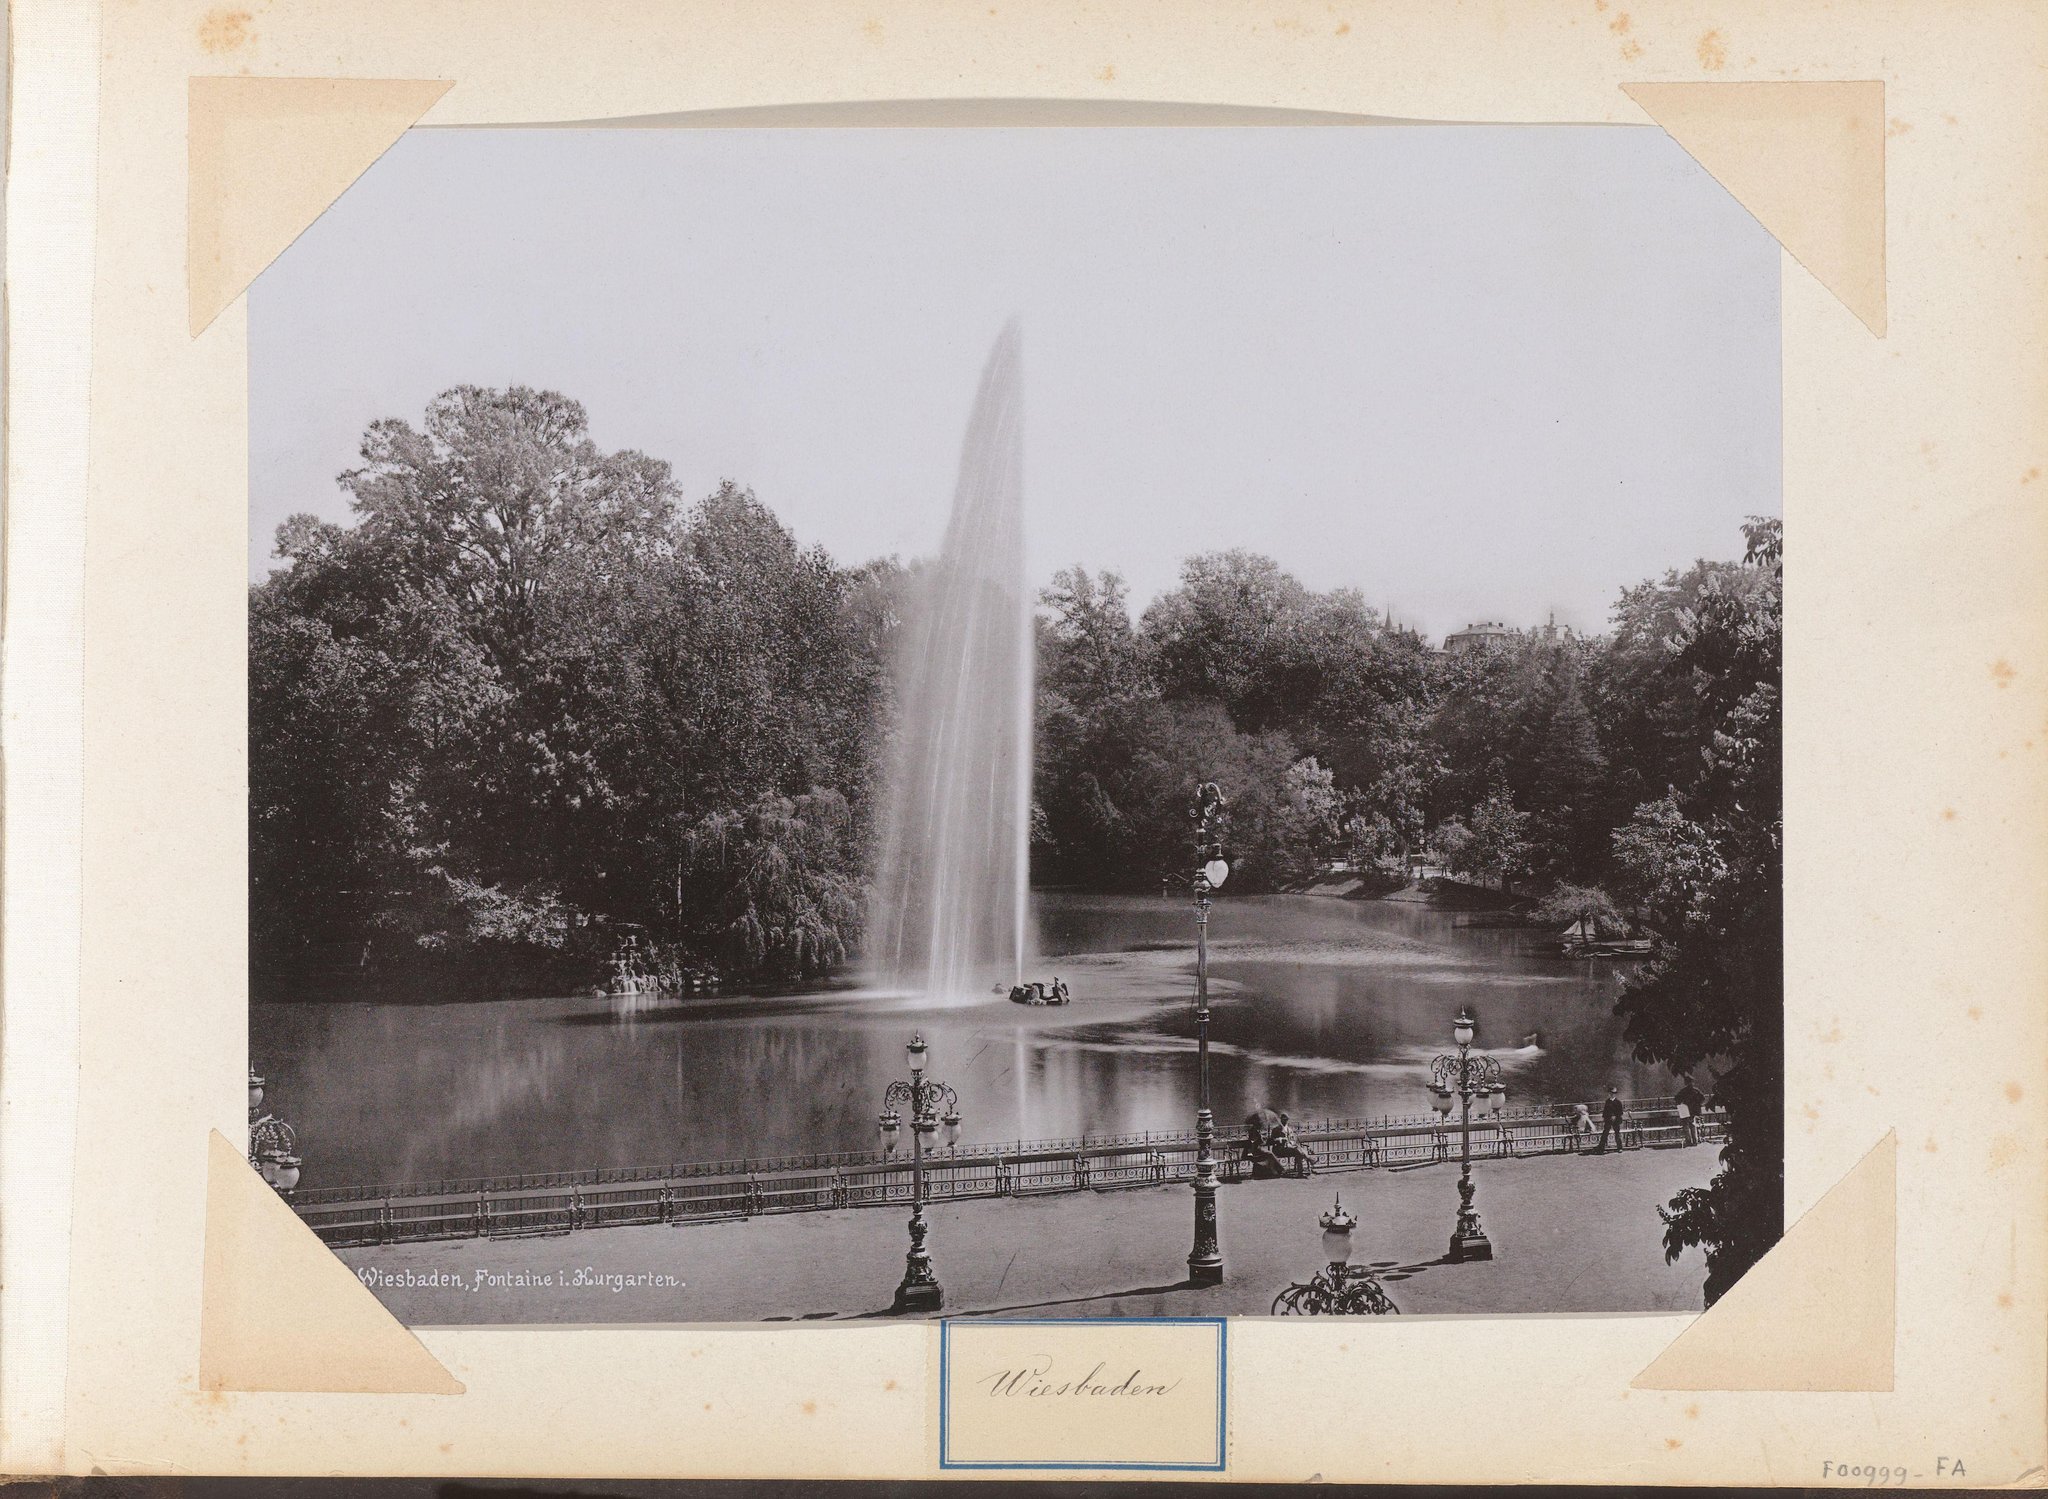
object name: photograph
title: Wiesbaden, Fontaine i. Kurgarten.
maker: Anonymous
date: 1890-1920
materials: paper, photographic support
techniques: photograph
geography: wiesbaden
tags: garden fountain, watering-place, spa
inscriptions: negative number: ‘5’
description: Onderdeel van Album met 191 foto's van een reis naar en door Zuid-Afrika.